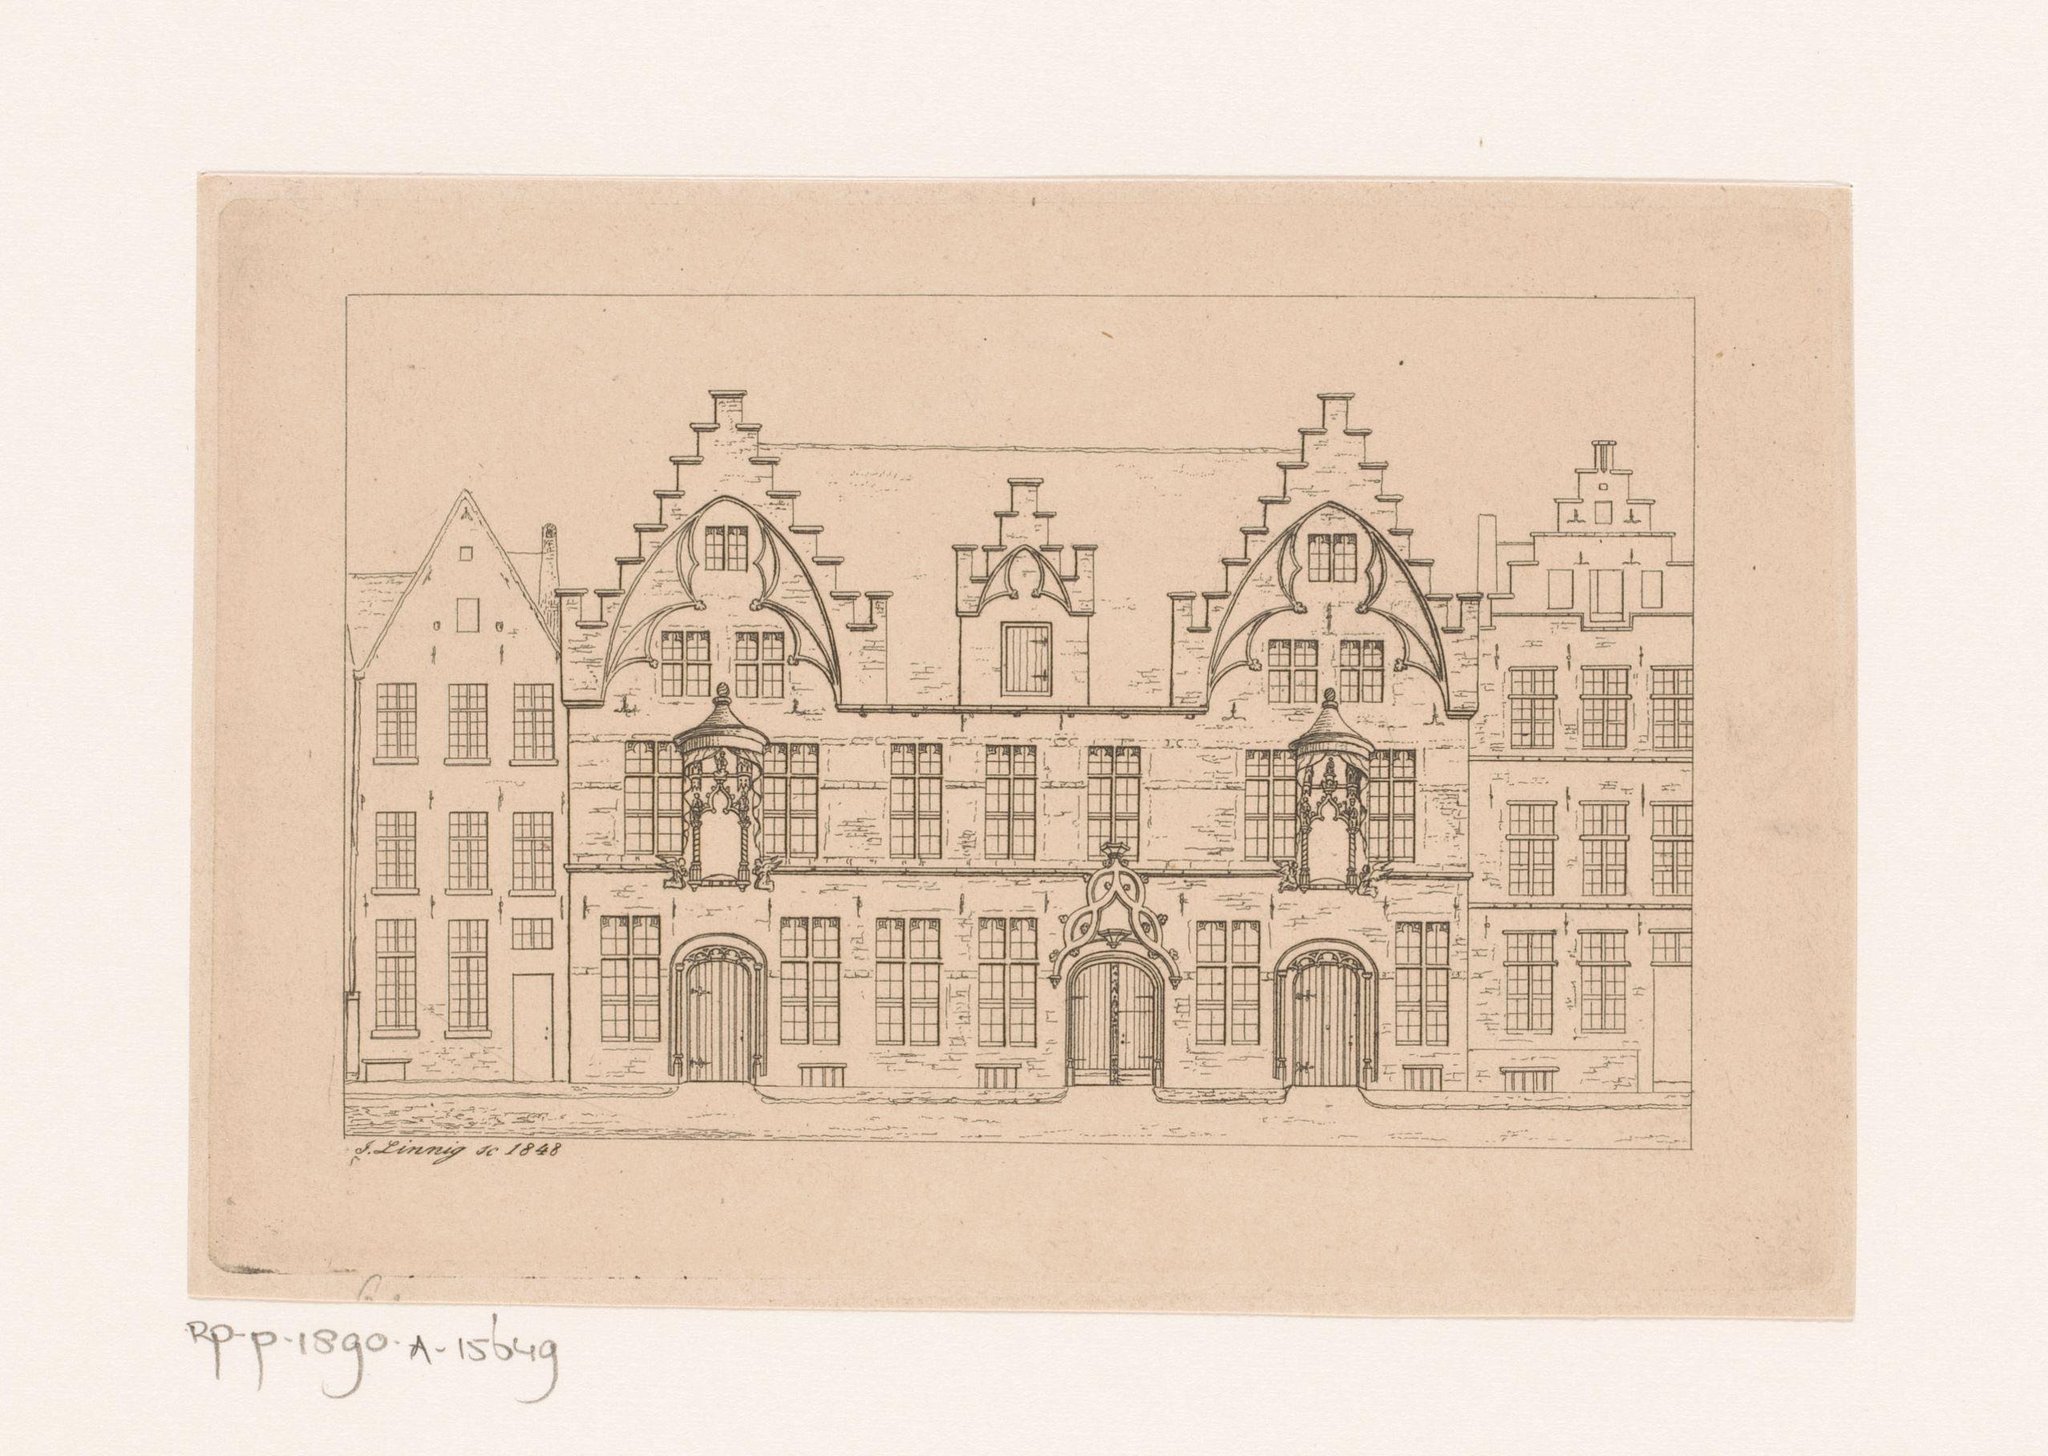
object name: print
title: Oude woning in Lier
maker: jean théodore joseph linnig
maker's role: draughtsman, print maker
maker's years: 1815-1891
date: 1848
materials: paper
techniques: etching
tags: urban housing, lierre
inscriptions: collector's mark: Lugt 2228